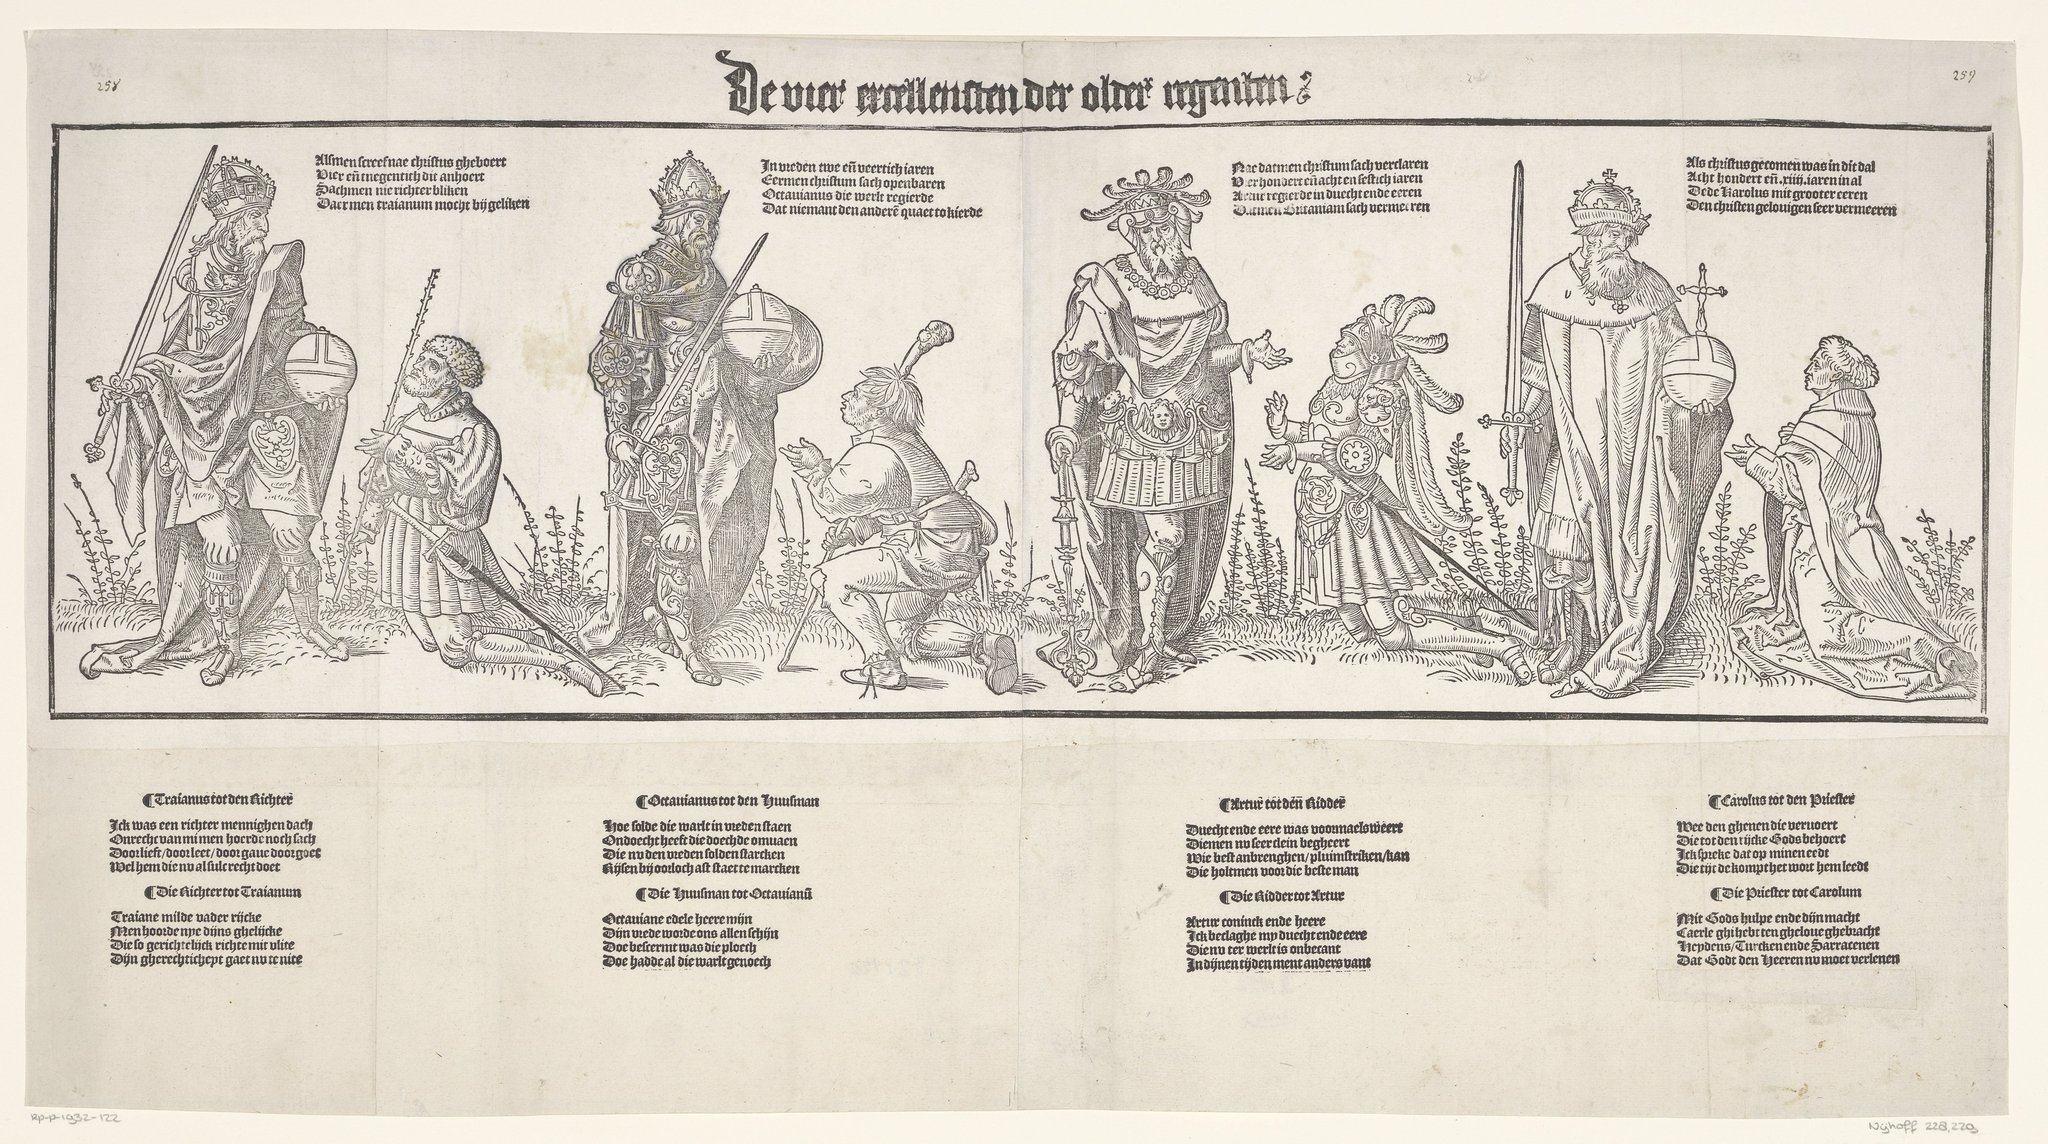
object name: print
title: De vier excellensten der older regenten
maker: cornelis anthonisz.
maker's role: draughtsman, painter, print maker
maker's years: 1499-1553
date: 1509-1553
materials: paper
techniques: letterpress printing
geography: amsterdam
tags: kneeling figure, kneeling before a ruler, regent, substitute ruler; viceroy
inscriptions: collector's mark: Lugt 2228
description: Vier rijkgeklede regenten met elk een knielend figuur voor zich, waaronder een ridder en een priester. Daar omheen twaalf kolommen met Nederlandse tekst in boekdruk.